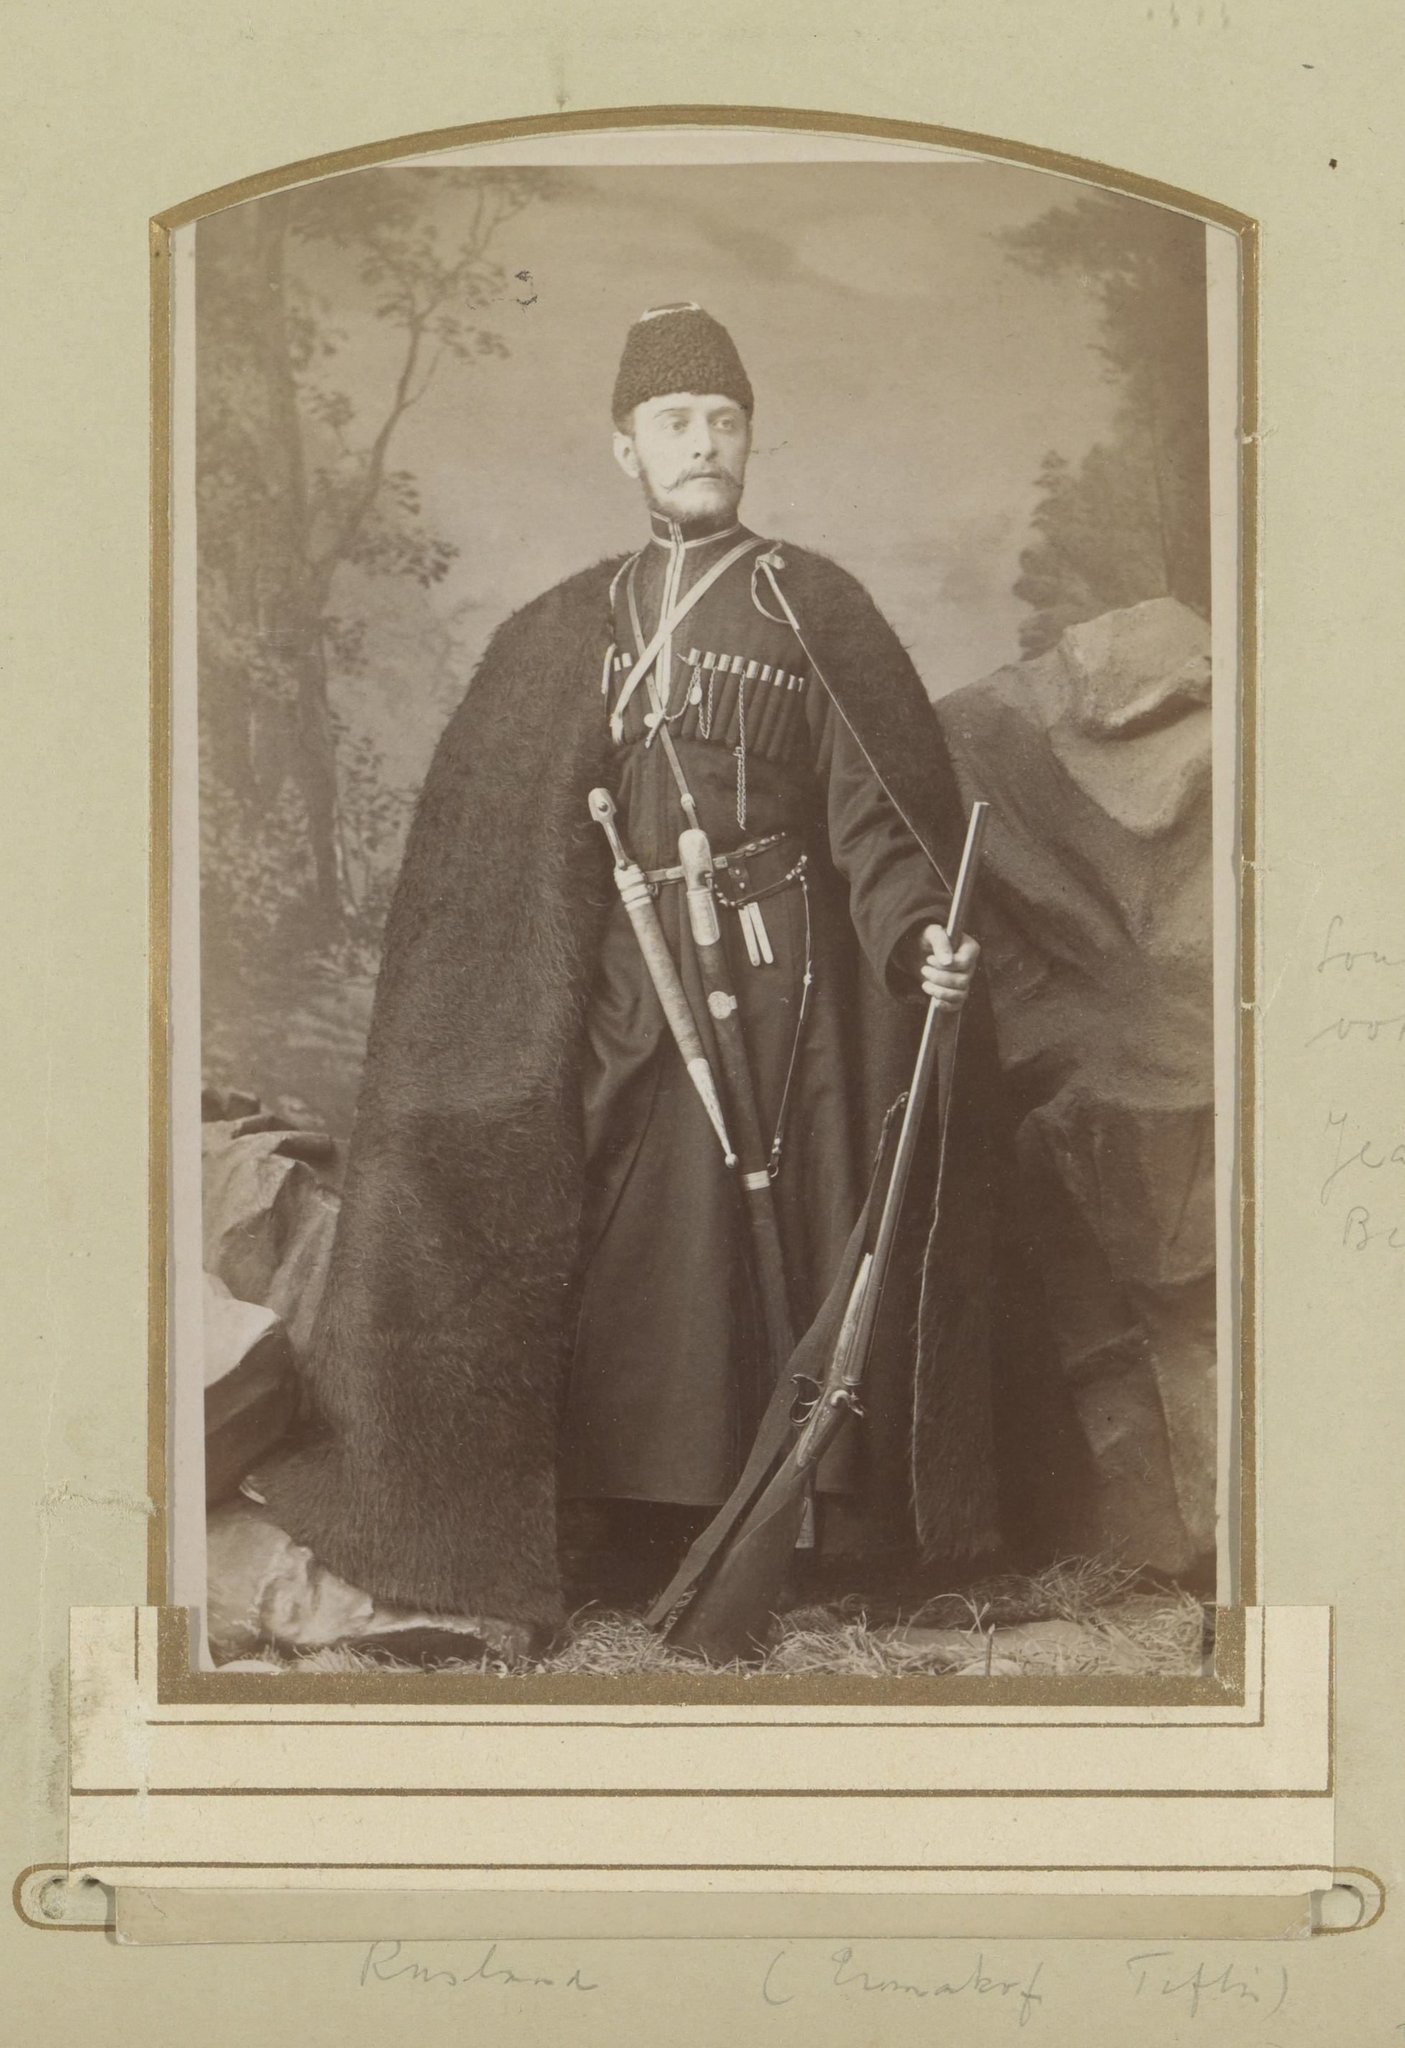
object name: cabinet photograph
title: Portret van een (vermoedelijk) Russische militair, staand met een bontmantel, bontmuts en wapens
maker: dimitri ivanovitch ermakov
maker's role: fotograaf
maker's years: 1845-1916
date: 1860-1900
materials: cardboard, paper, photographic support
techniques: albumen print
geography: tbilisi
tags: studio requisites ~ photographer, head-gear (with name), firearms: rifle, warfare; military affairs, (military) uniforms, division of armed forces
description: Onderdeel van Album met cartes-de-visite en kabinetfoto's van militairen in uniform.